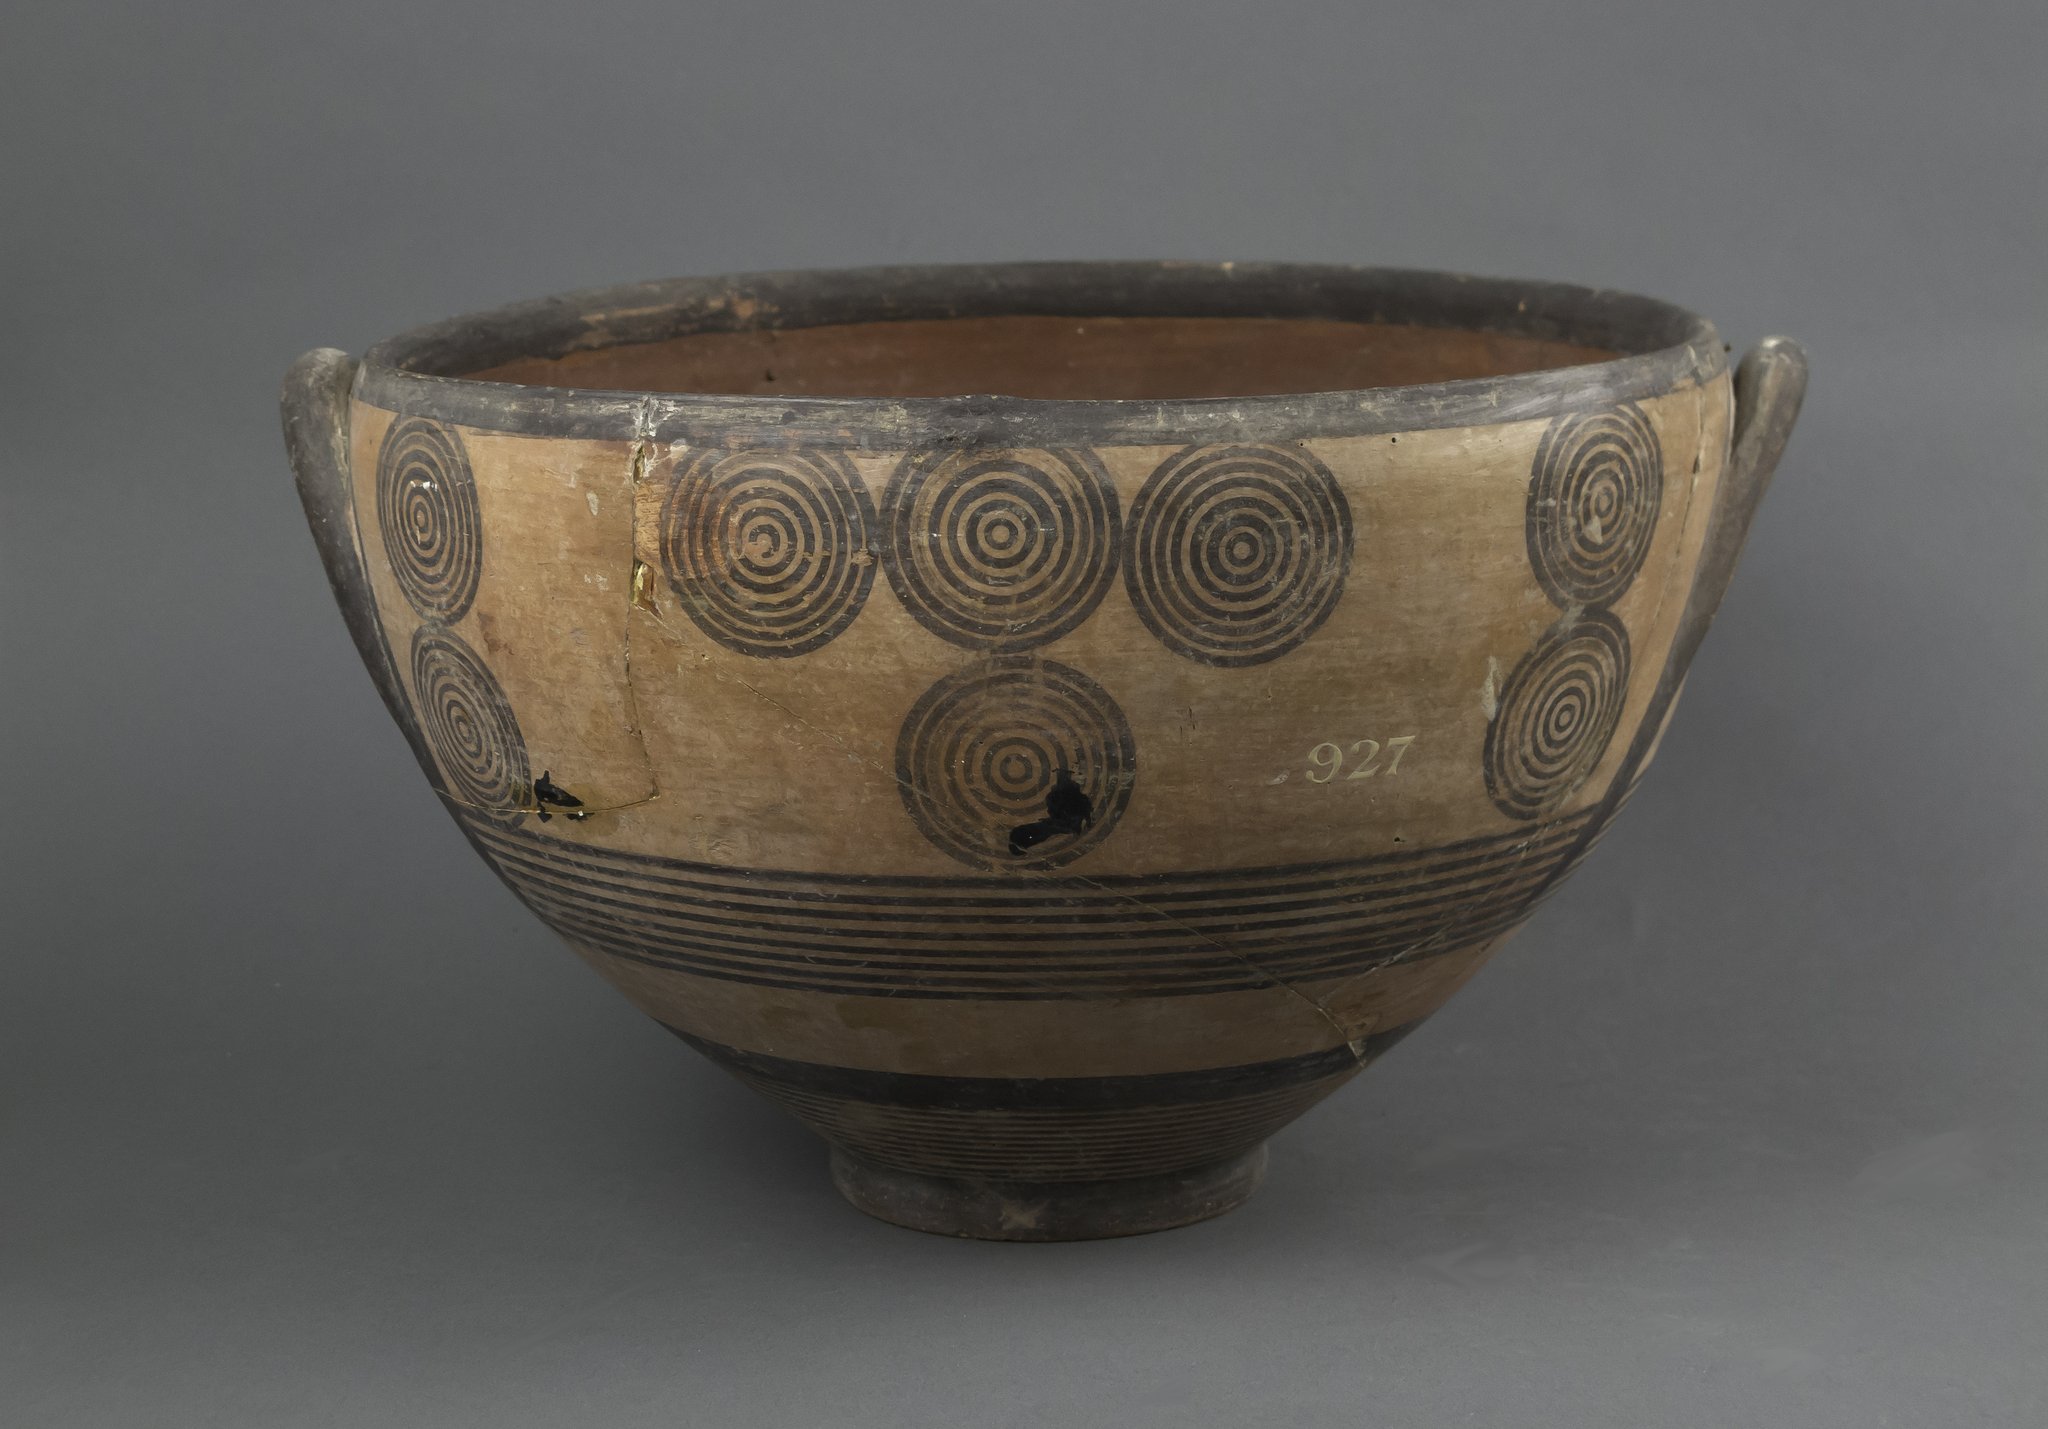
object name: bowl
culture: cypriot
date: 507-323 BCE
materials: terracotta